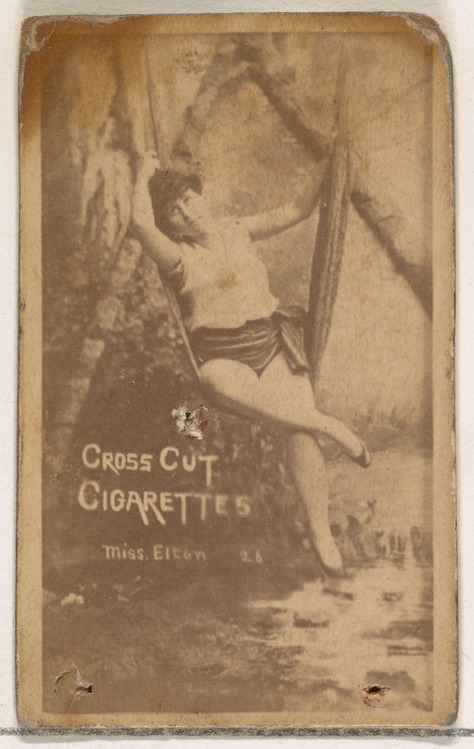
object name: print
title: Card Number 26, Miss Elton, from the Actors and Actresses series (N145-1) issued by Duke Sons & Co. to promote Cross Cut Cigarettes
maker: w. duke, sons & co.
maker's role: publisher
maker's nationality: american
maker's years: 1870-1920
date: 1880-1889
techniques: albumen silver print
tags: portraits,women,actresses